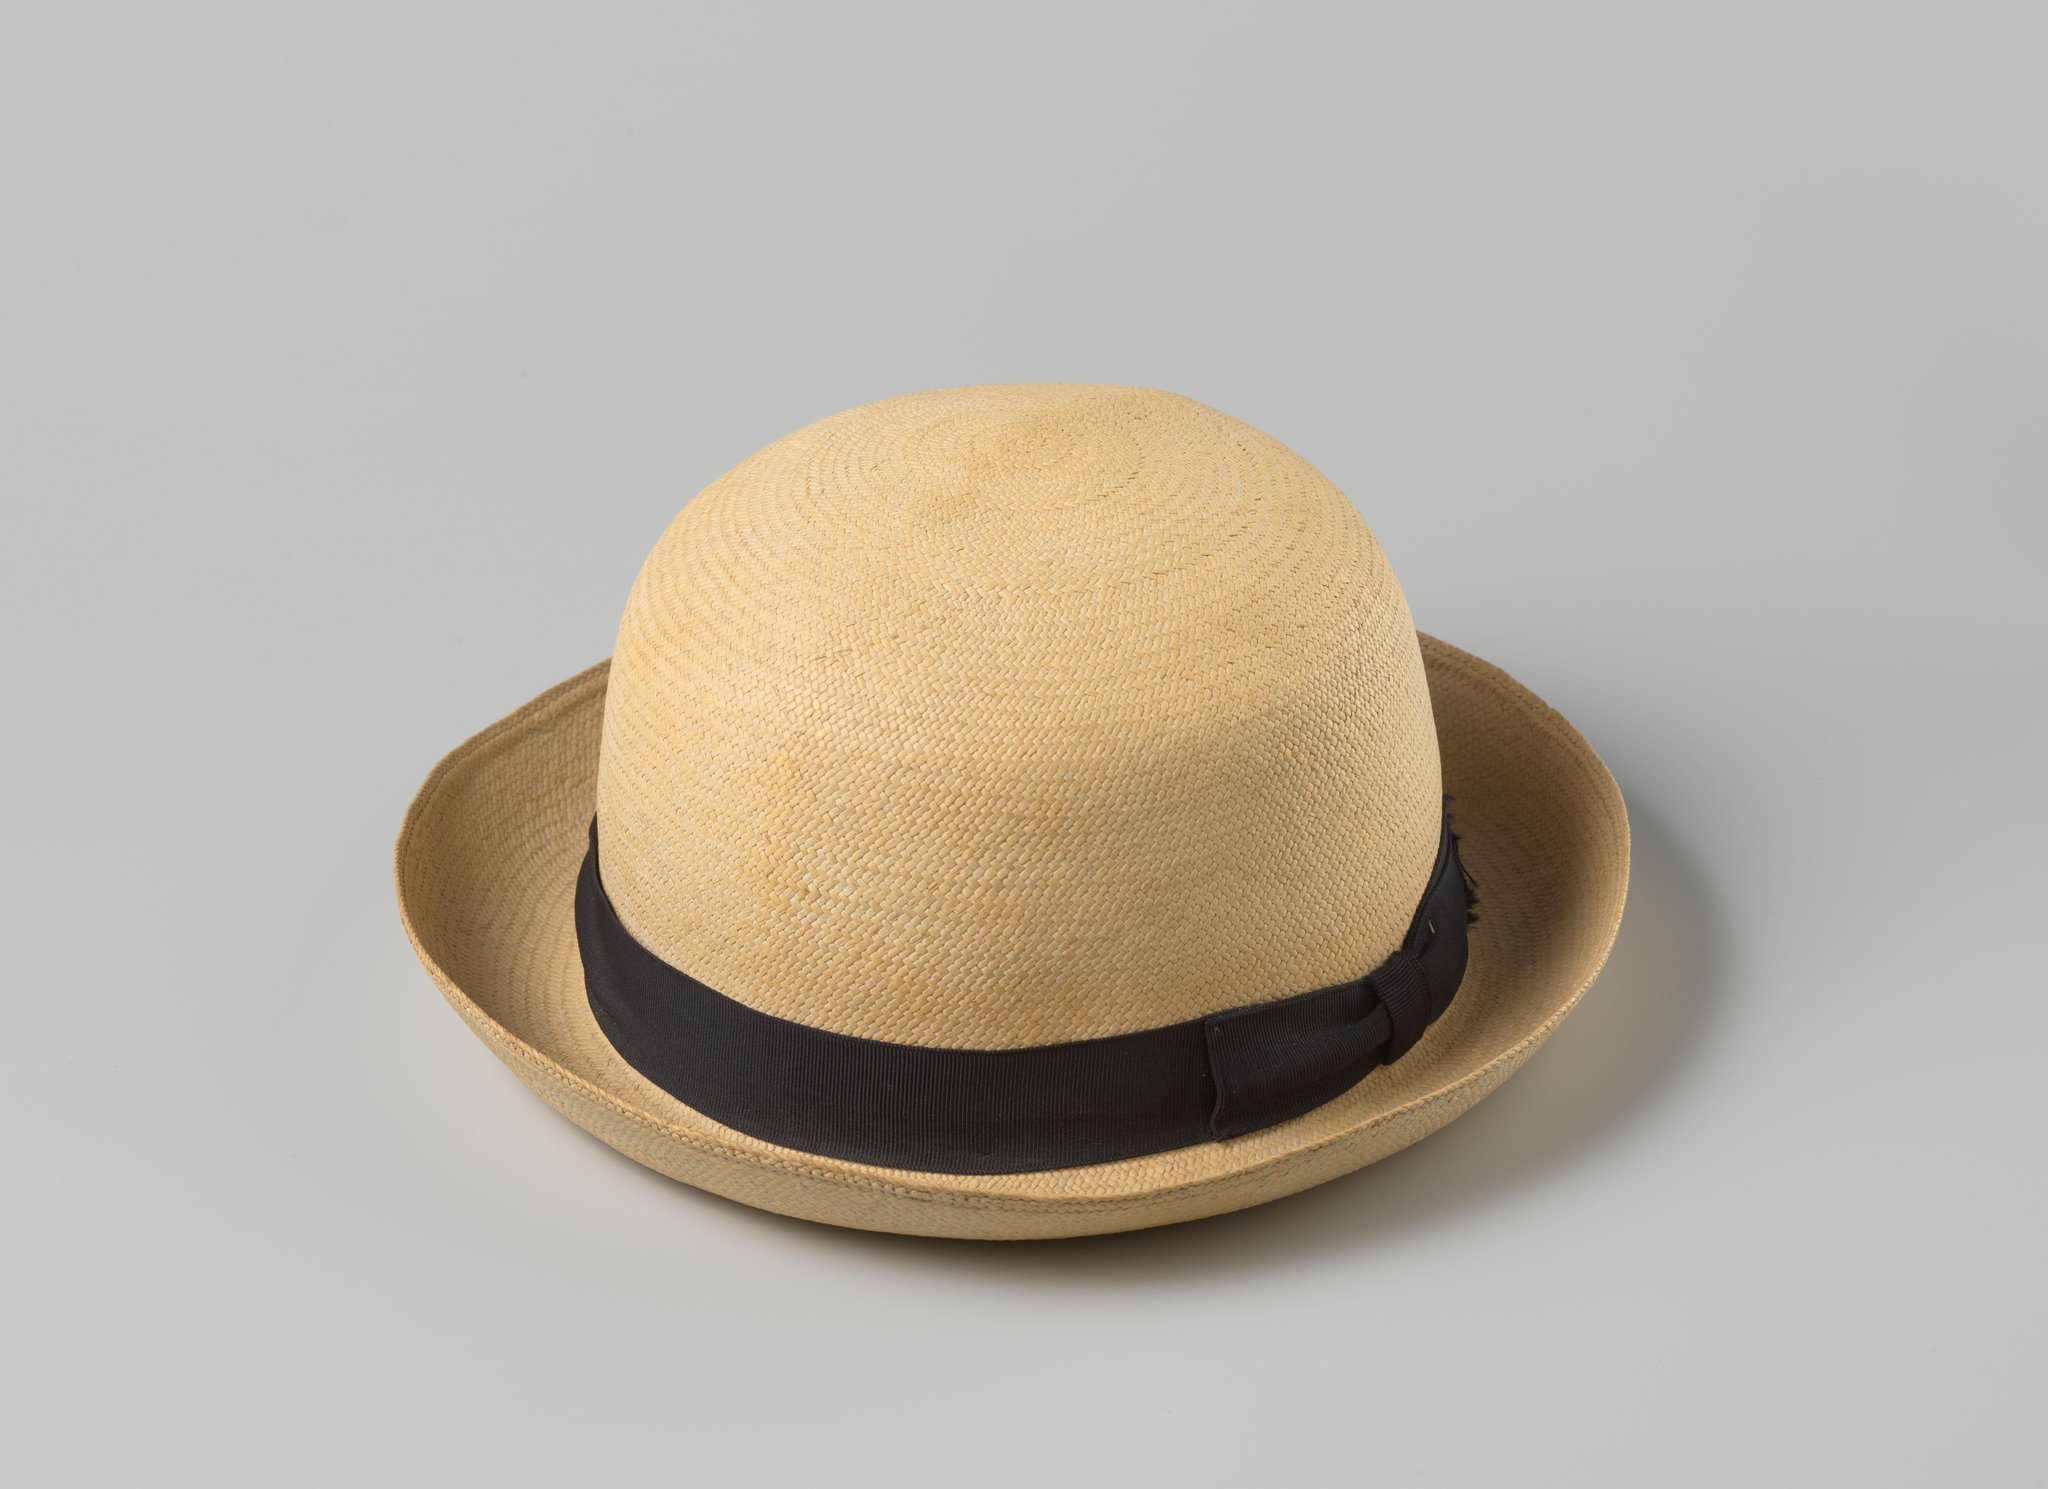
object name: kinderhoed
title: Kinderhoed van Panamastro met band van zwart grosgrain; aan de binnenzijde de initialen G.J.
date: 1935-1940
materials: textile, straw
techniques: strohalm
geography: quimper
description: Kinderhoed van Panamastro met band van zwart grosgrain. Aan de binnenzijde van de hoed de initialen G.J. Eveneens op de binnenrand een stempel waarop staat: Chapellerie Menguy/ Quimper.